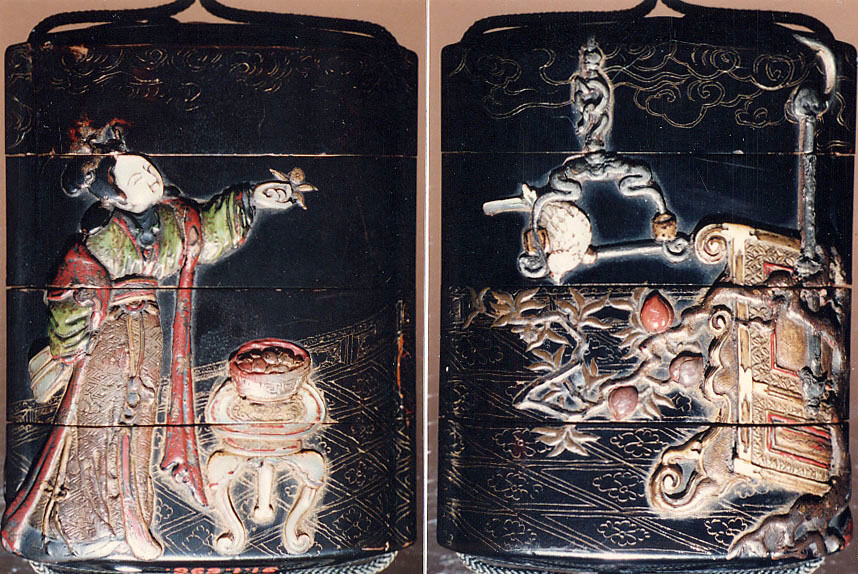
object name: inrō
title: Case (Inrō) with Design of Chinese Woman at Court Feeding a Parrot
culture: japanese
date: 1767-1800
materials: ceramic, coral, gold, ivory, lacquer, metal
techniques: incising, inlay, roiro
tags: women,parrots